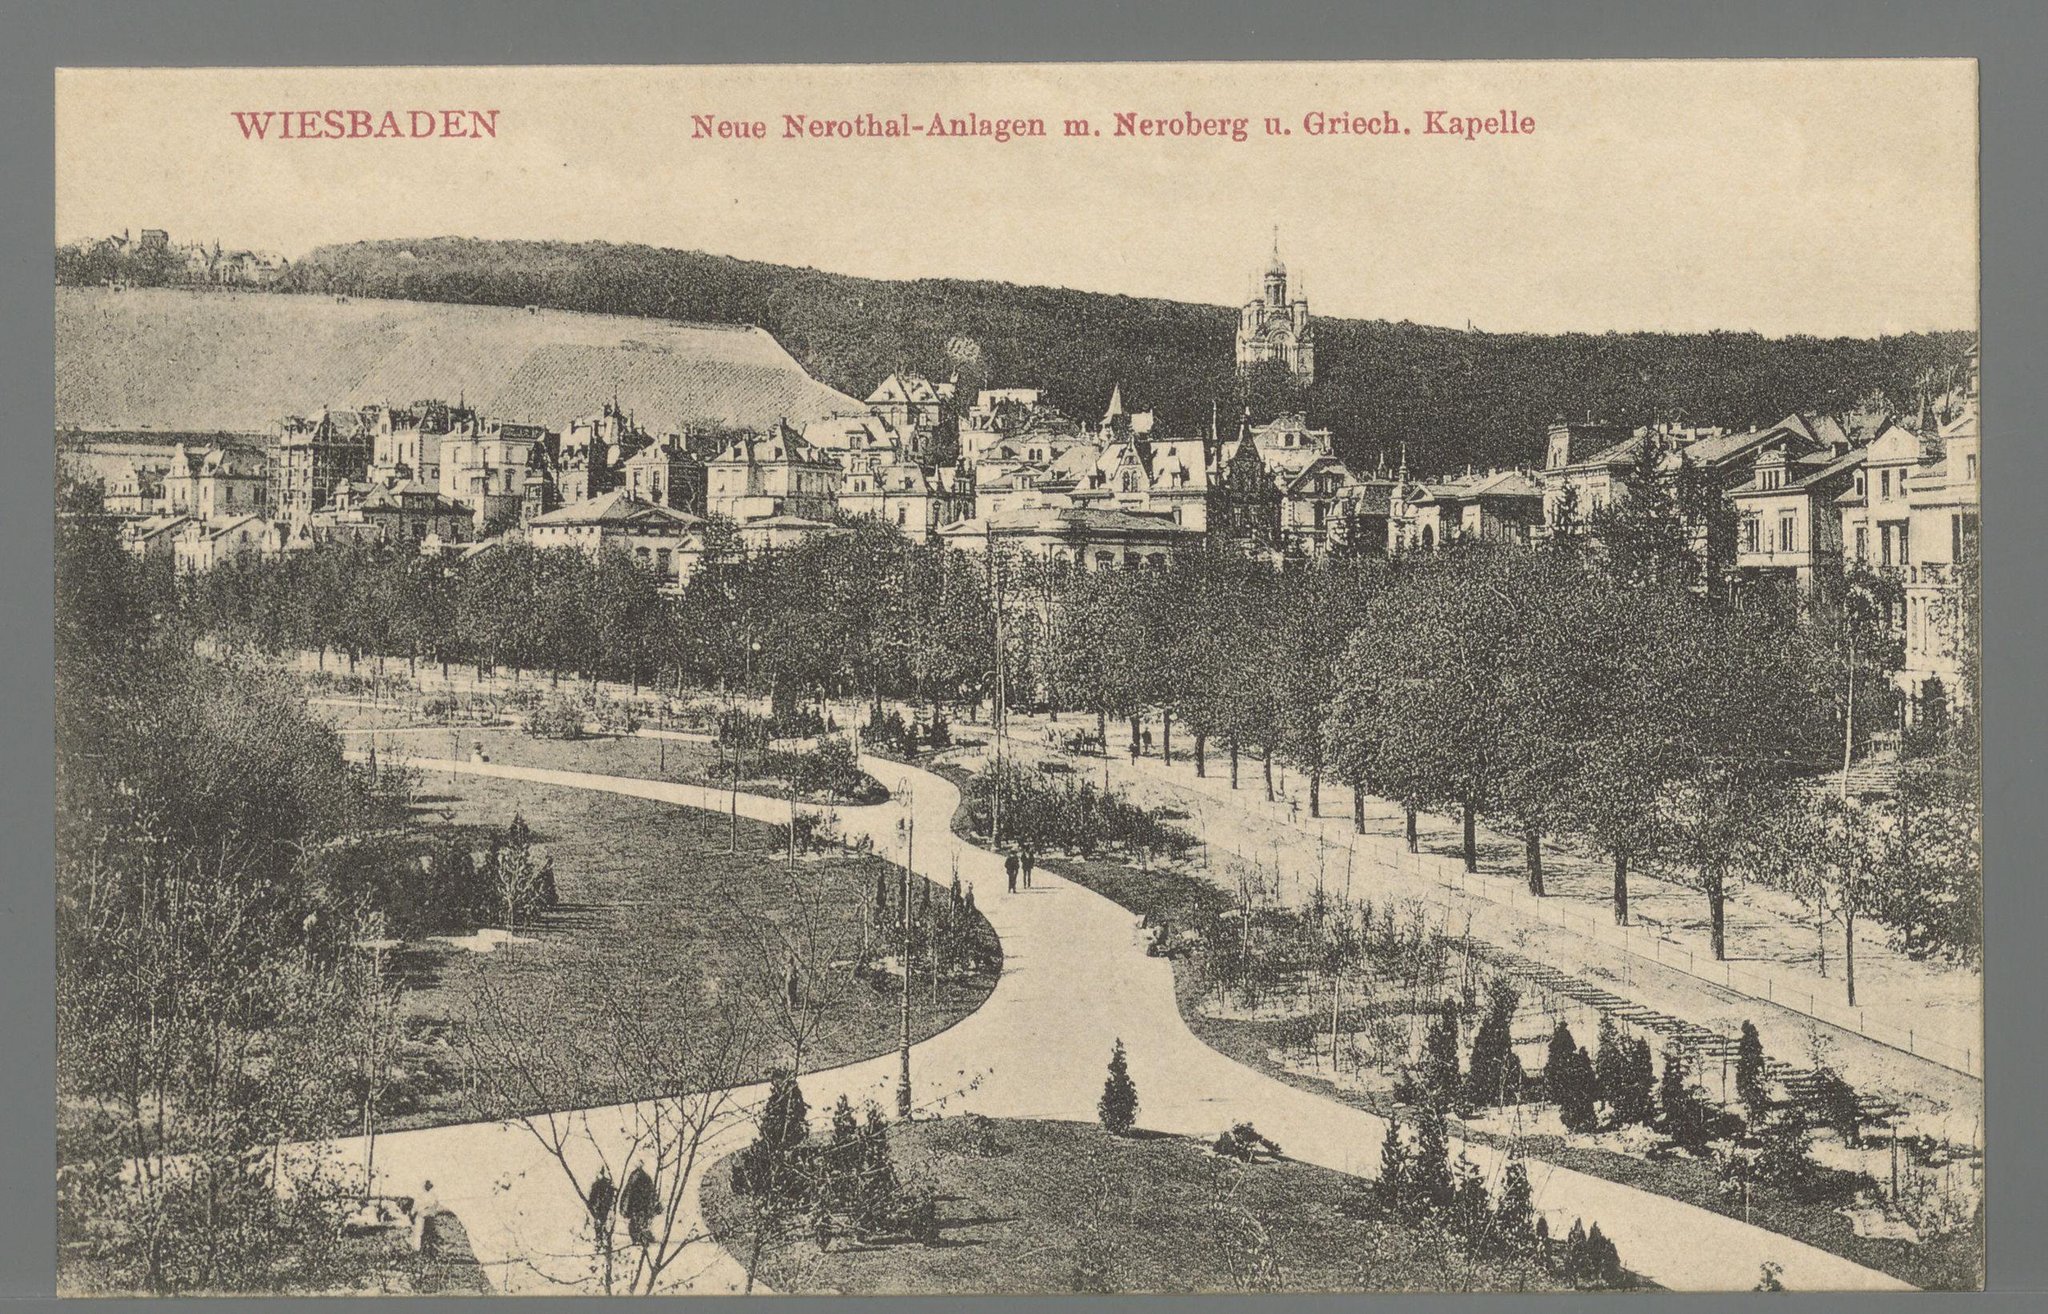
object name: photomechanical print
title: Wiesbaden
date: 1907-1908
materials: cardboard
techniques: photograph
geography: wiesbaden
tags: landscapes in the temperate zone